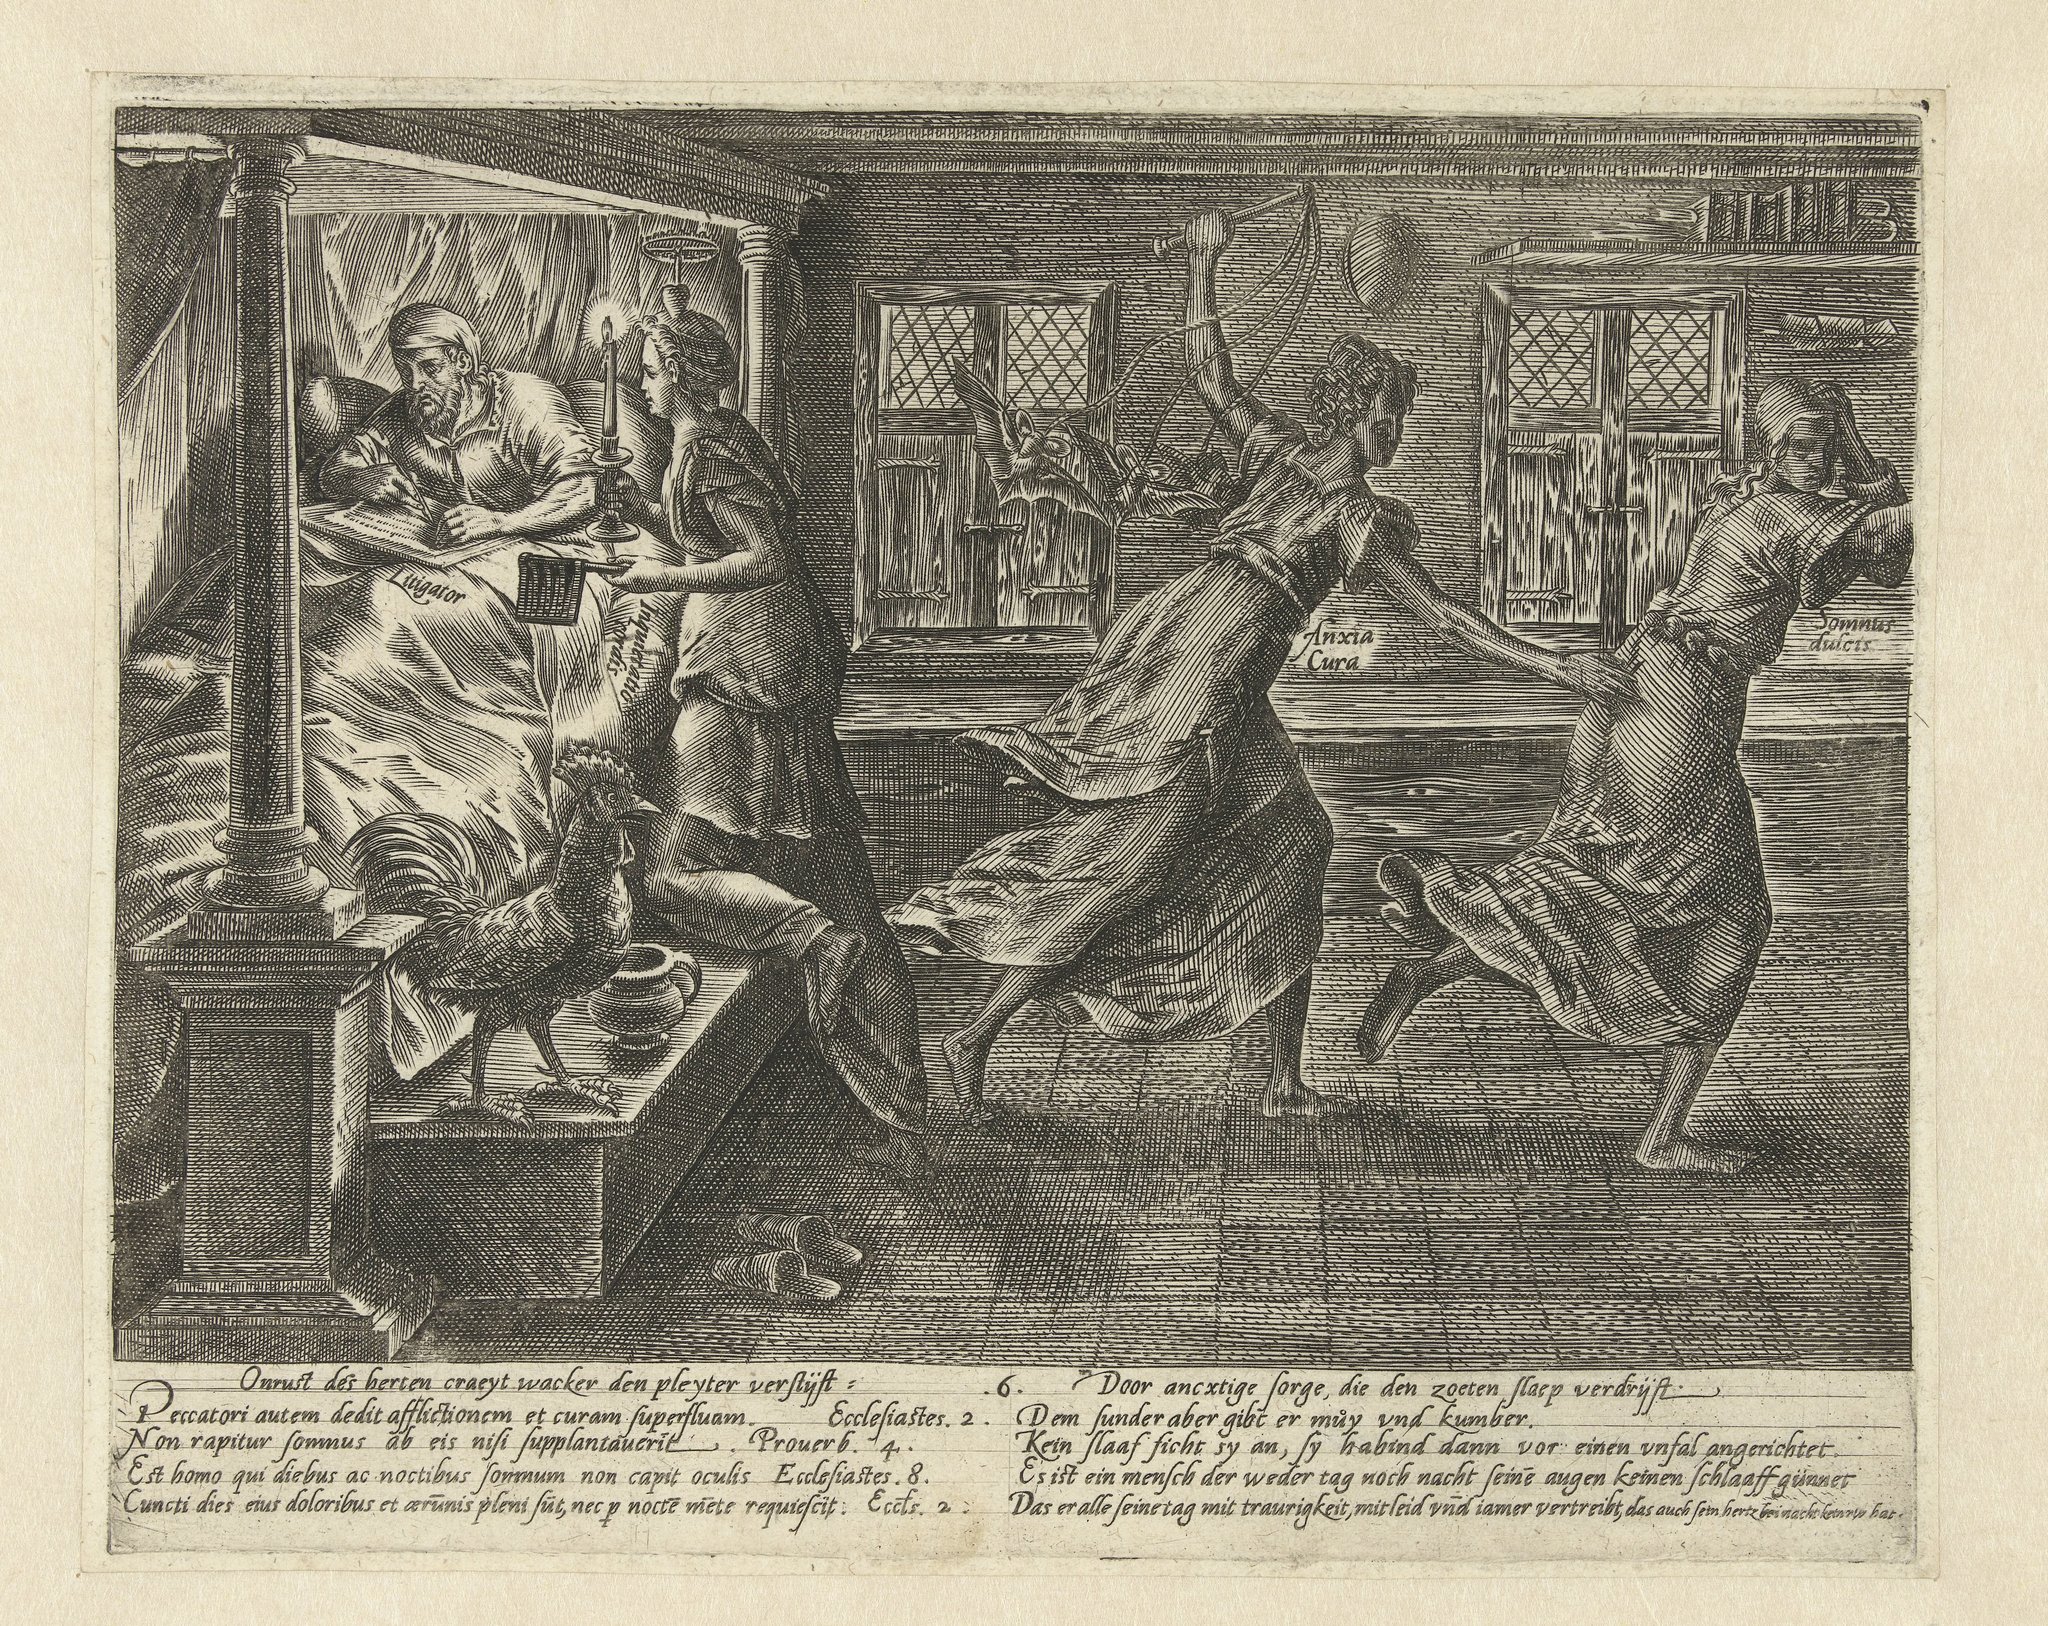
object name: print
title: Misbruik van de procesvoering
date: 1597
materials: paper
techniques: engraving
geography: haarlem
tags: fowl (cock, hen, chicken, etc.), litigation, legal proceedings, lawsuit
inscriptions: collector's mark: Lugt 2228a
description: De procederende mens (Litigator) zit in bed te schrijven, wakker gehouden door een haan en Ongerustheid (met ratel). Angstige Zorg verjaagt Zachte Slaap. Uitvoerig onderschrift in Nederlands, Duits en Latijn. Deze prent is onderdeel van een serie van acht prenten over hebzucht, bedrog en procederen.